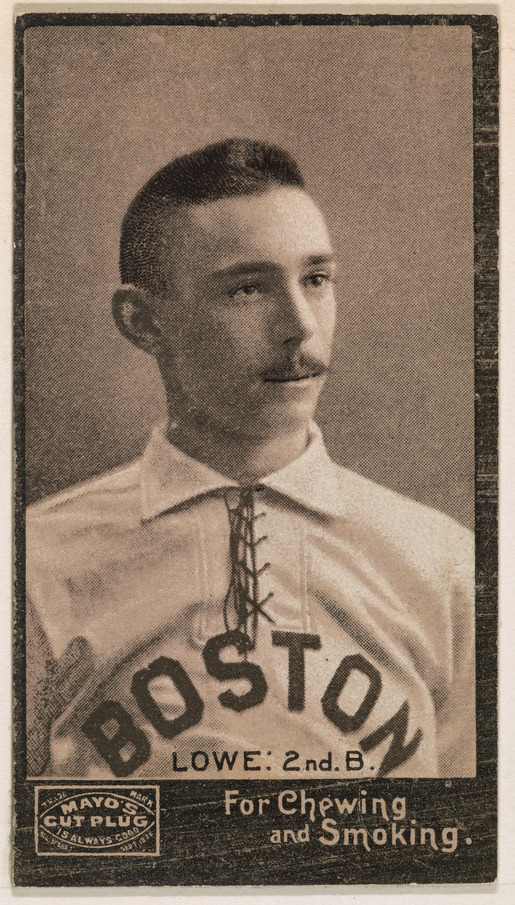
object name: print, baseball card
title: Lowe, 2nd Base, Boston, from Mayo's Cut Plug Baseball series (N300)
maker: p.h. mayo & brother, richmond, virginia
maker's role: publisher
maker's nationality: american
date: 1895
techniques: lithography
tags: men,portraits,baseball,athletes